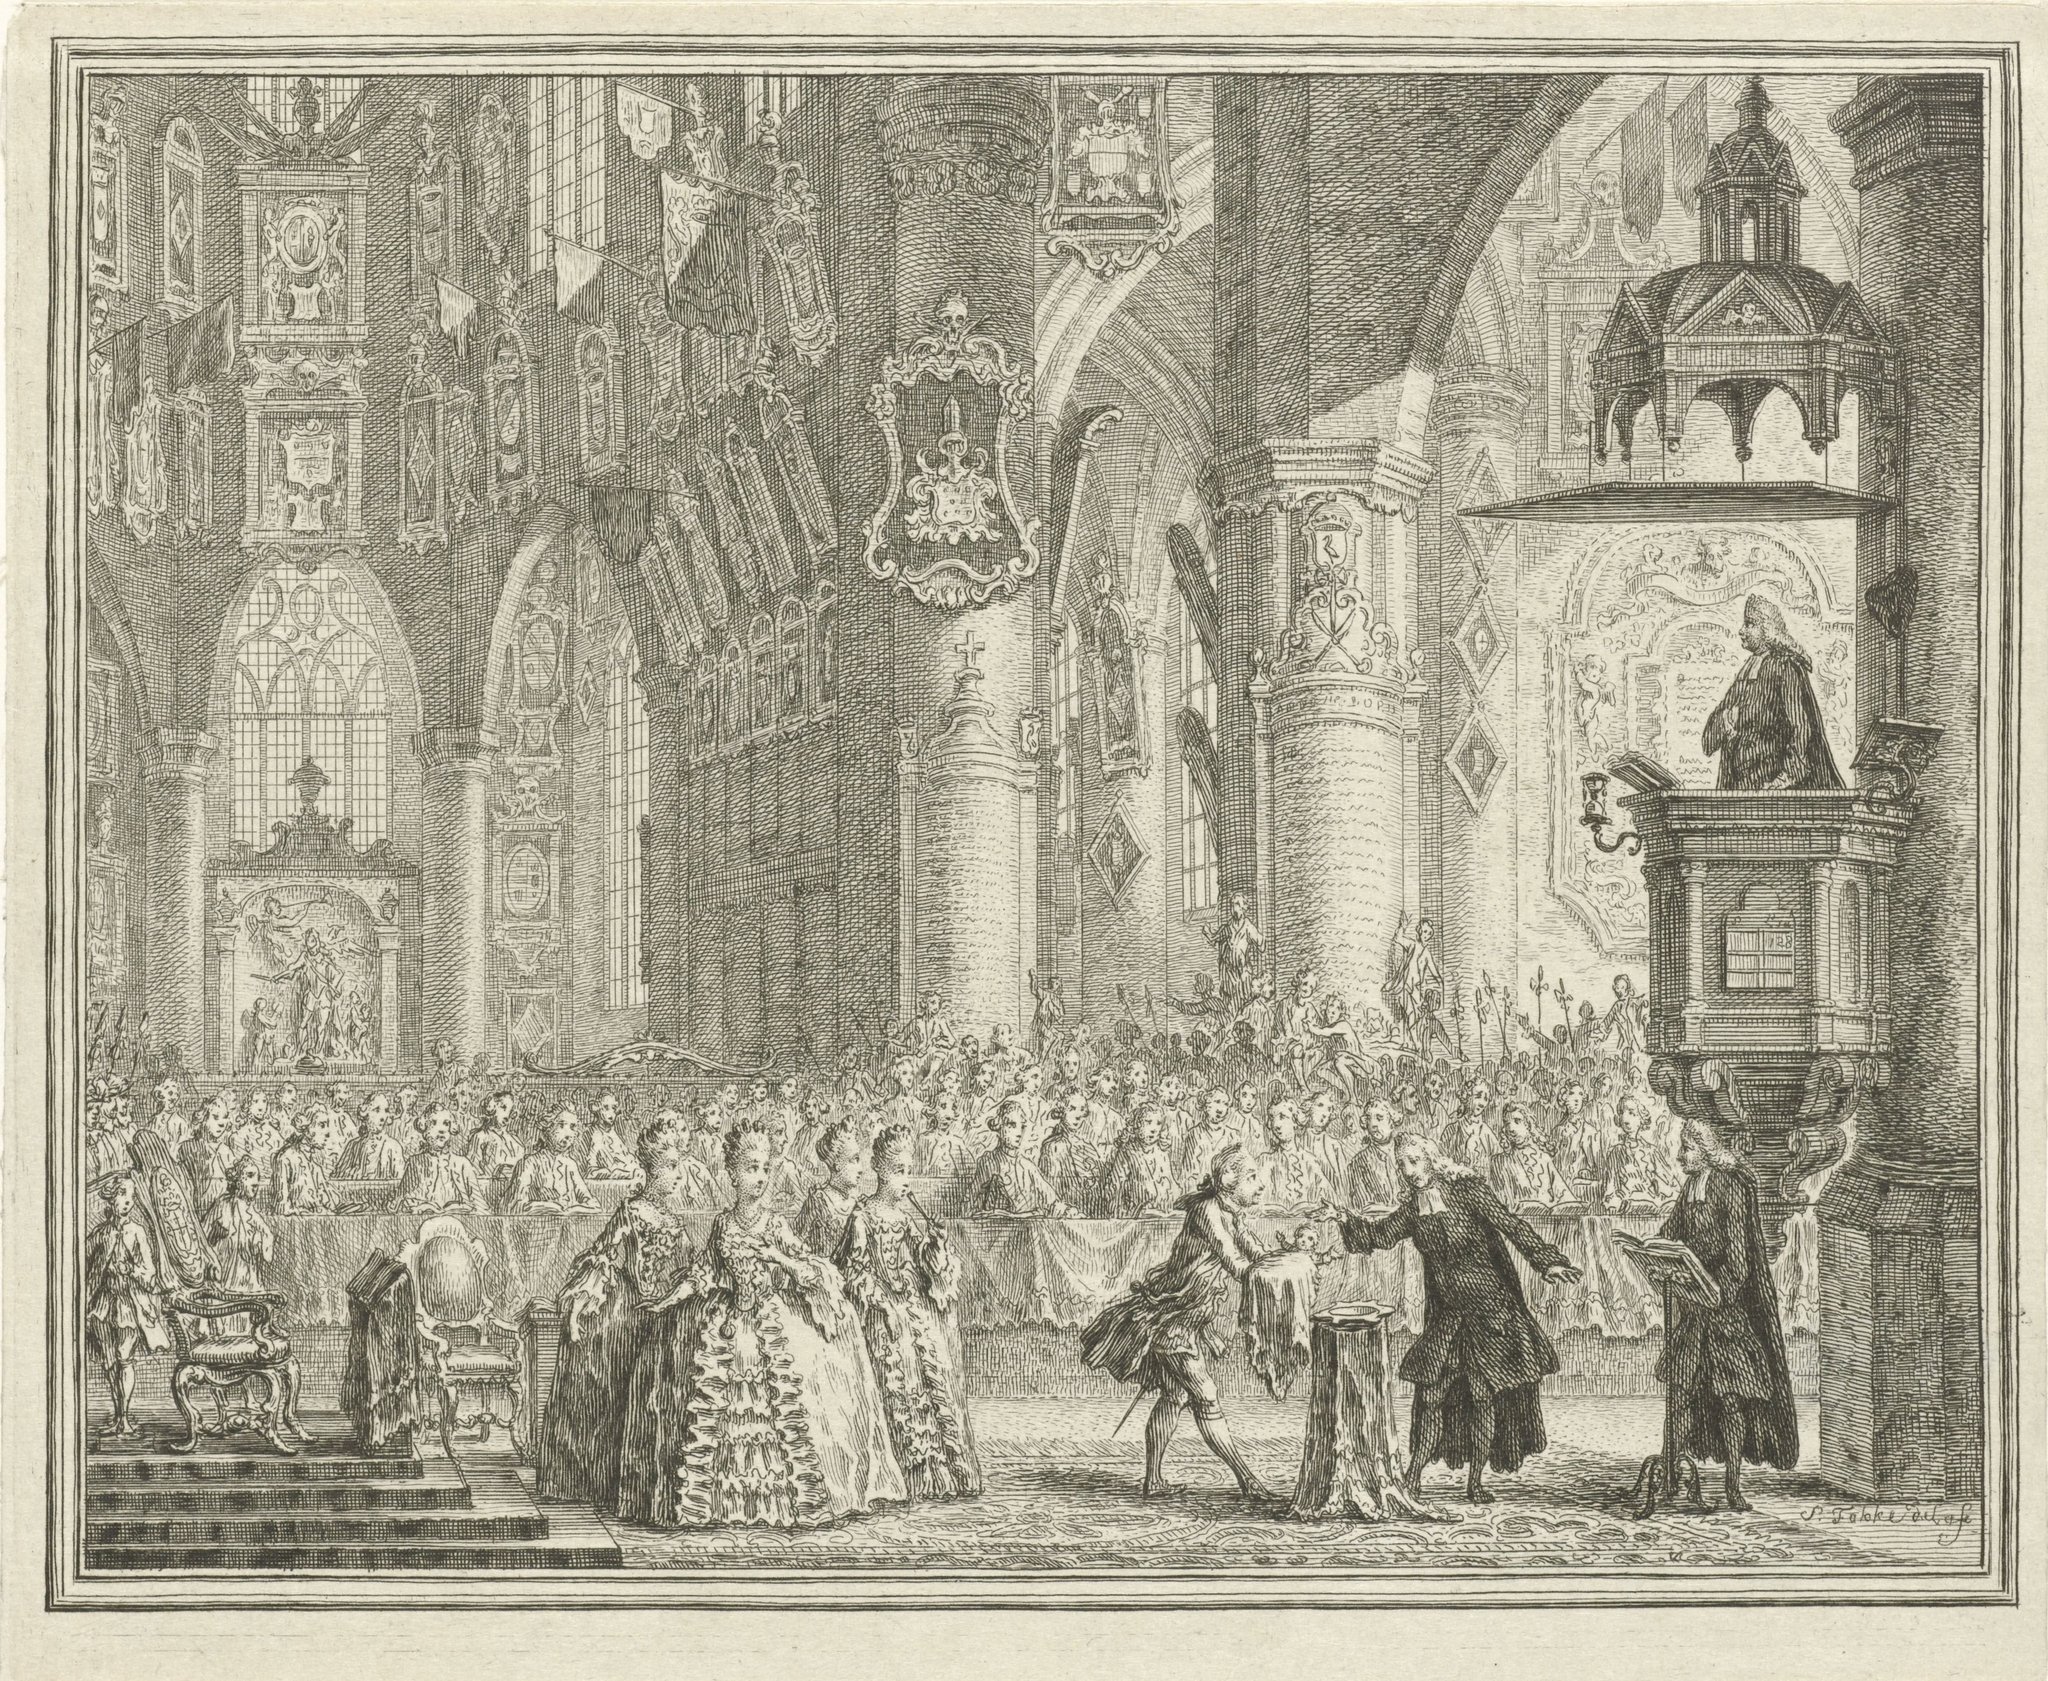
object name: print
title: Doop van prins Willem Frederik, 1772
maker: simon fokke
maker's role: draughtsman, print maker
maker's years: 1712-1784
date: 1772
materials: paper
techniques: engraving, etching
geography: northern netherlands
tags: the hague, william v (prince of orange), william i of the netherlands, painter, draughtsman, wilhelmina of prussia (princess of orange), baptism ~ protestant service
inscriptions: collector's mark: Lugt 2228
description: De doopplechtigheid van prins Willem Frederik, 17 september 1772 in de Grote Kerk te Den Haag. Prins Willem V houdt het kind ten doop, links prinses Wilhelmina van Pruisen met hofdames, rechts predikanten.